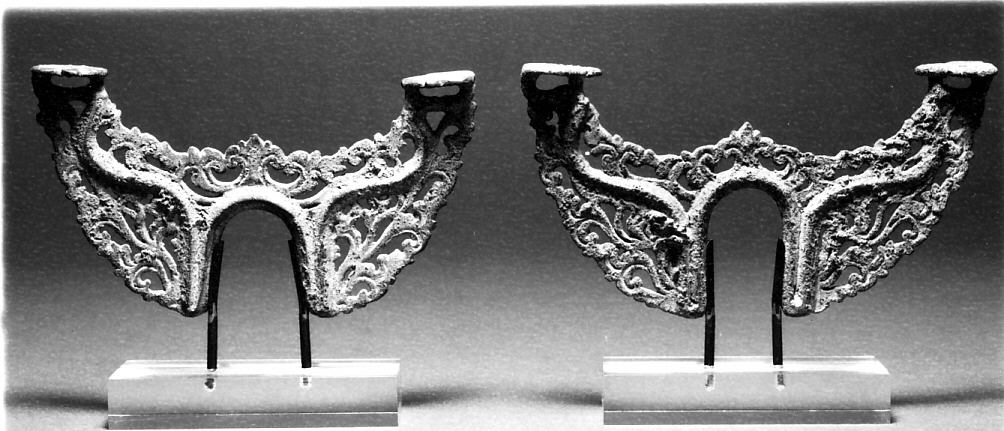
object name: suspension part for a musical instrument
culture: indonesian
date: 901-1100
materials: bronze